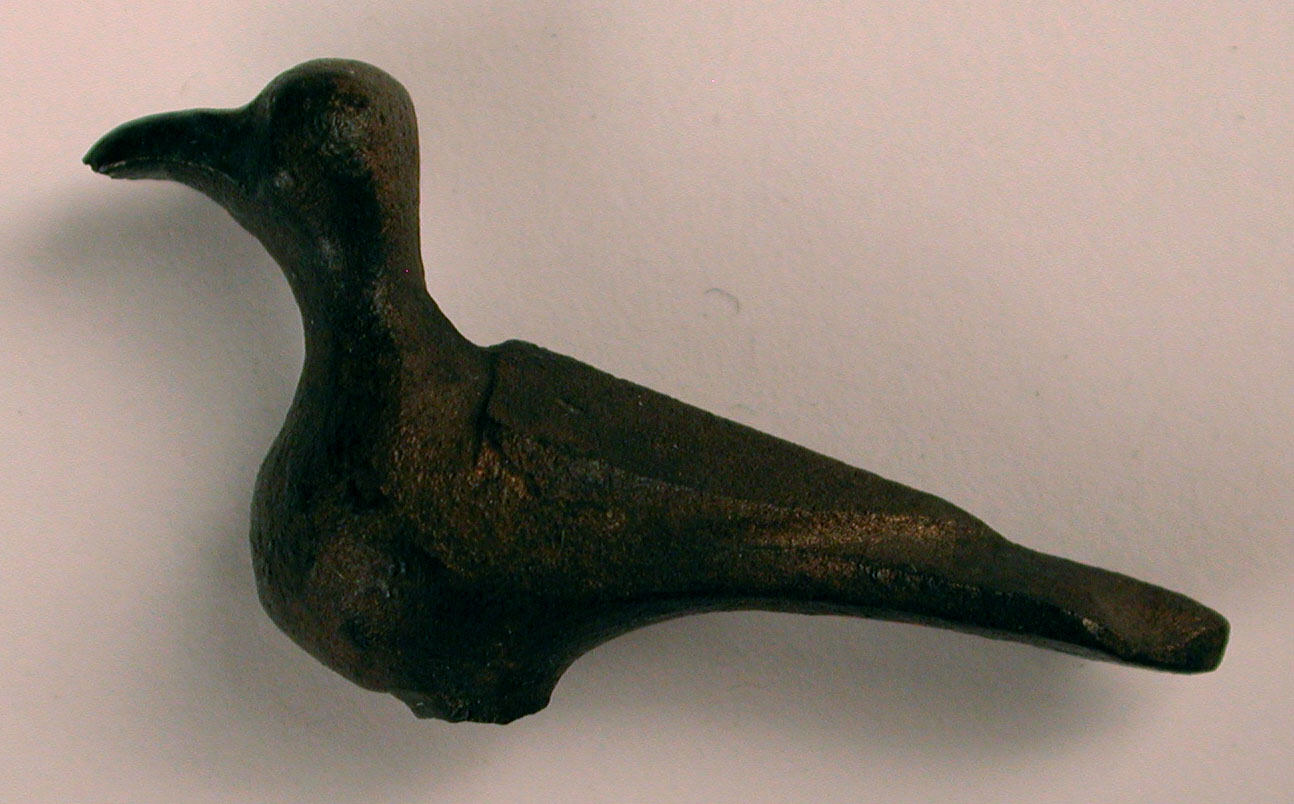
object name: pin fragment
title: Fragment of a Pin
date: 901-1000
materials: bronze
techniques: casting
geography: iran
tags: birds